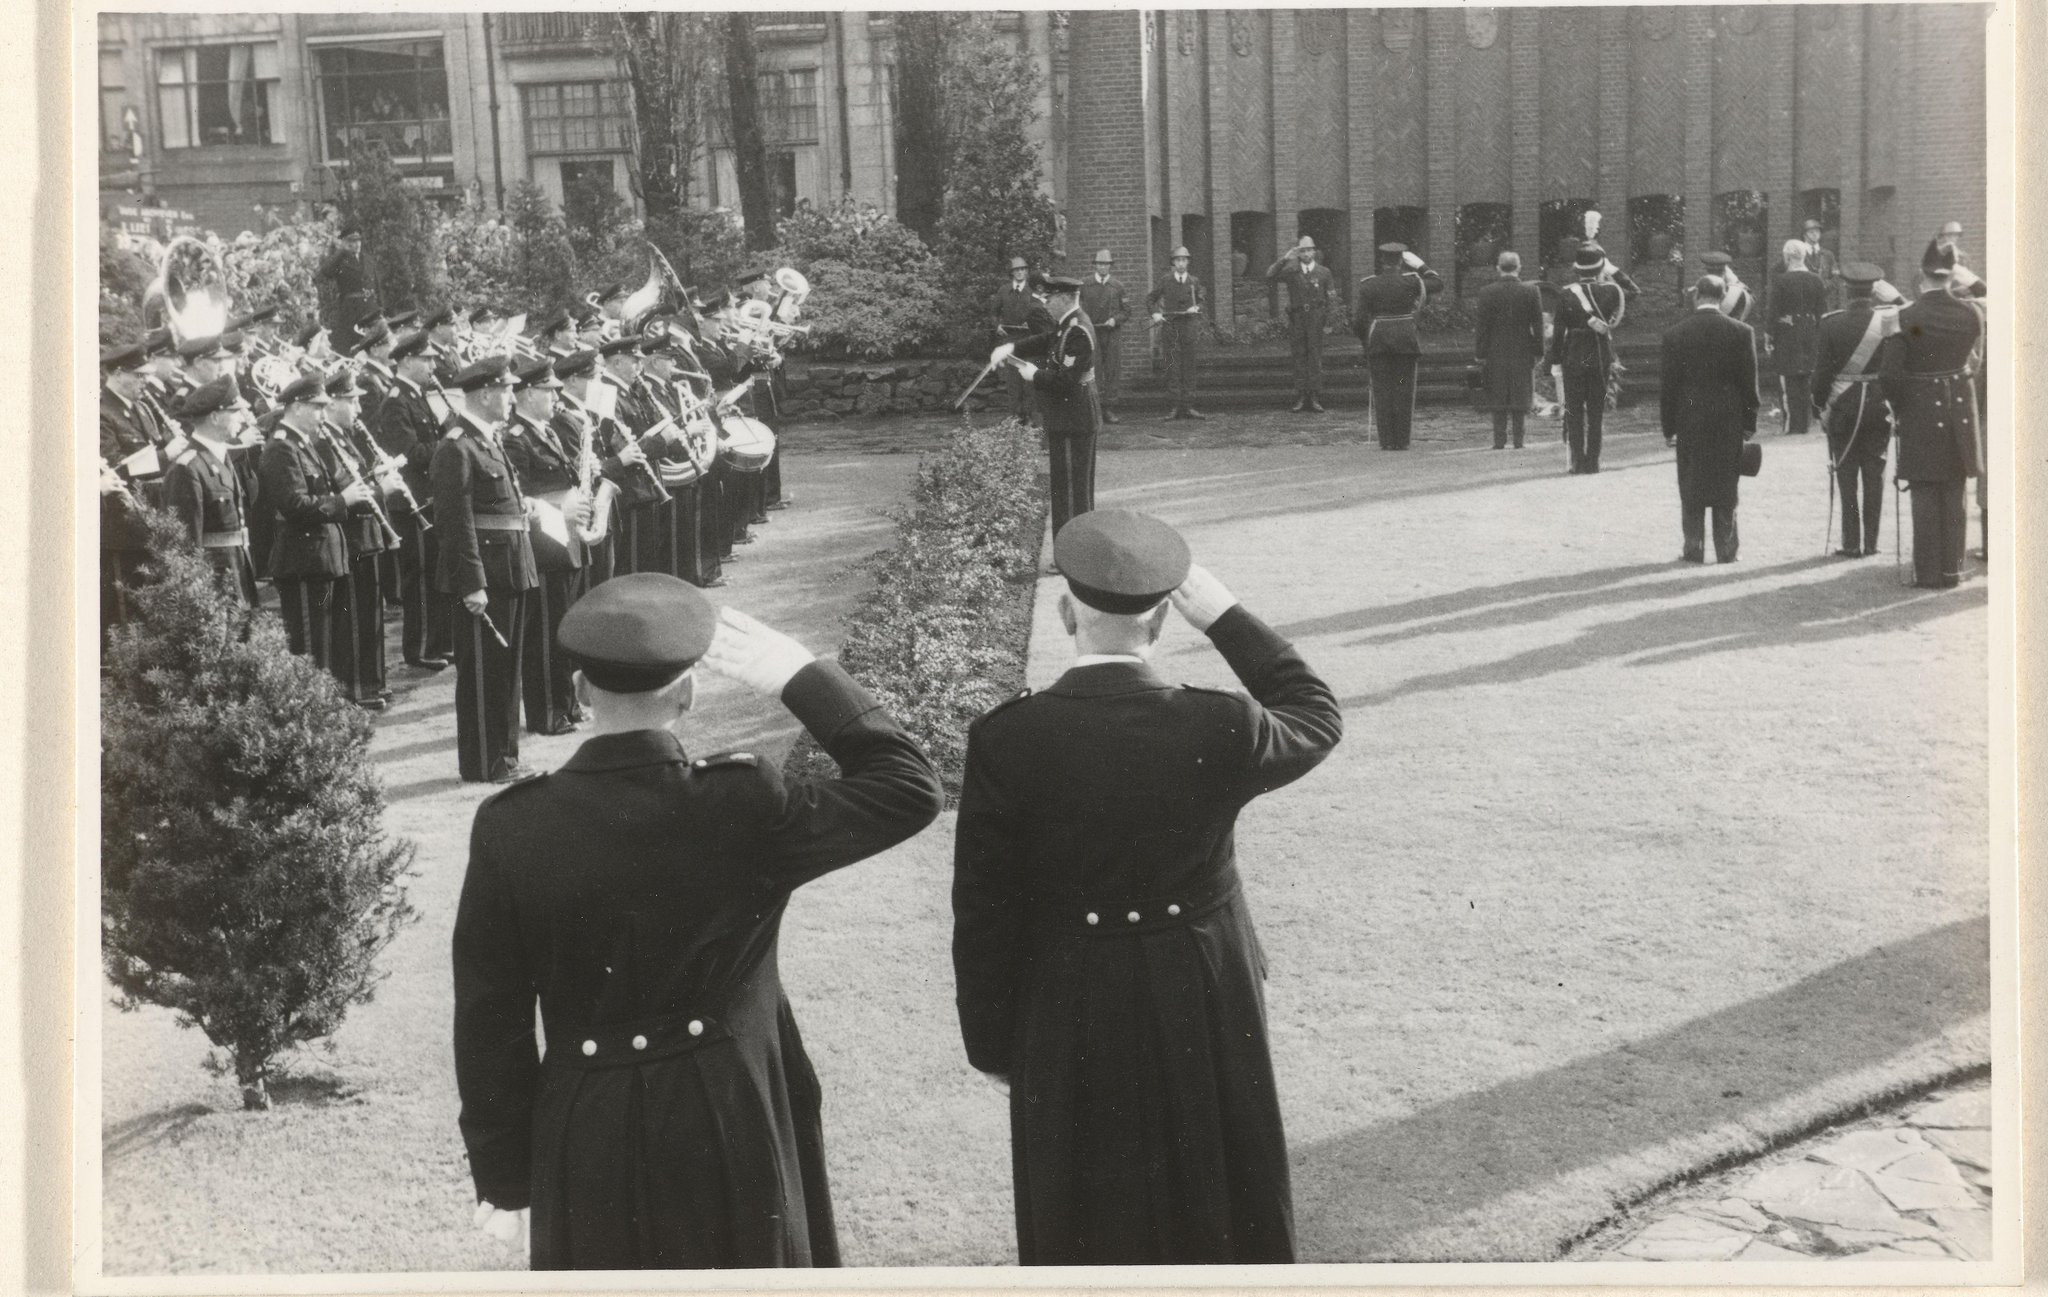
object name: photograph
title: Marine muziekgezelschap bij een oorlogsmonument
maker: Anonymous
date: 1954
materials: photographic support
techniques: gelatin silver print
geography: amsterdam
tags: musical instruments; group of musical instruments, making music; musician with instrument, other memorial structures